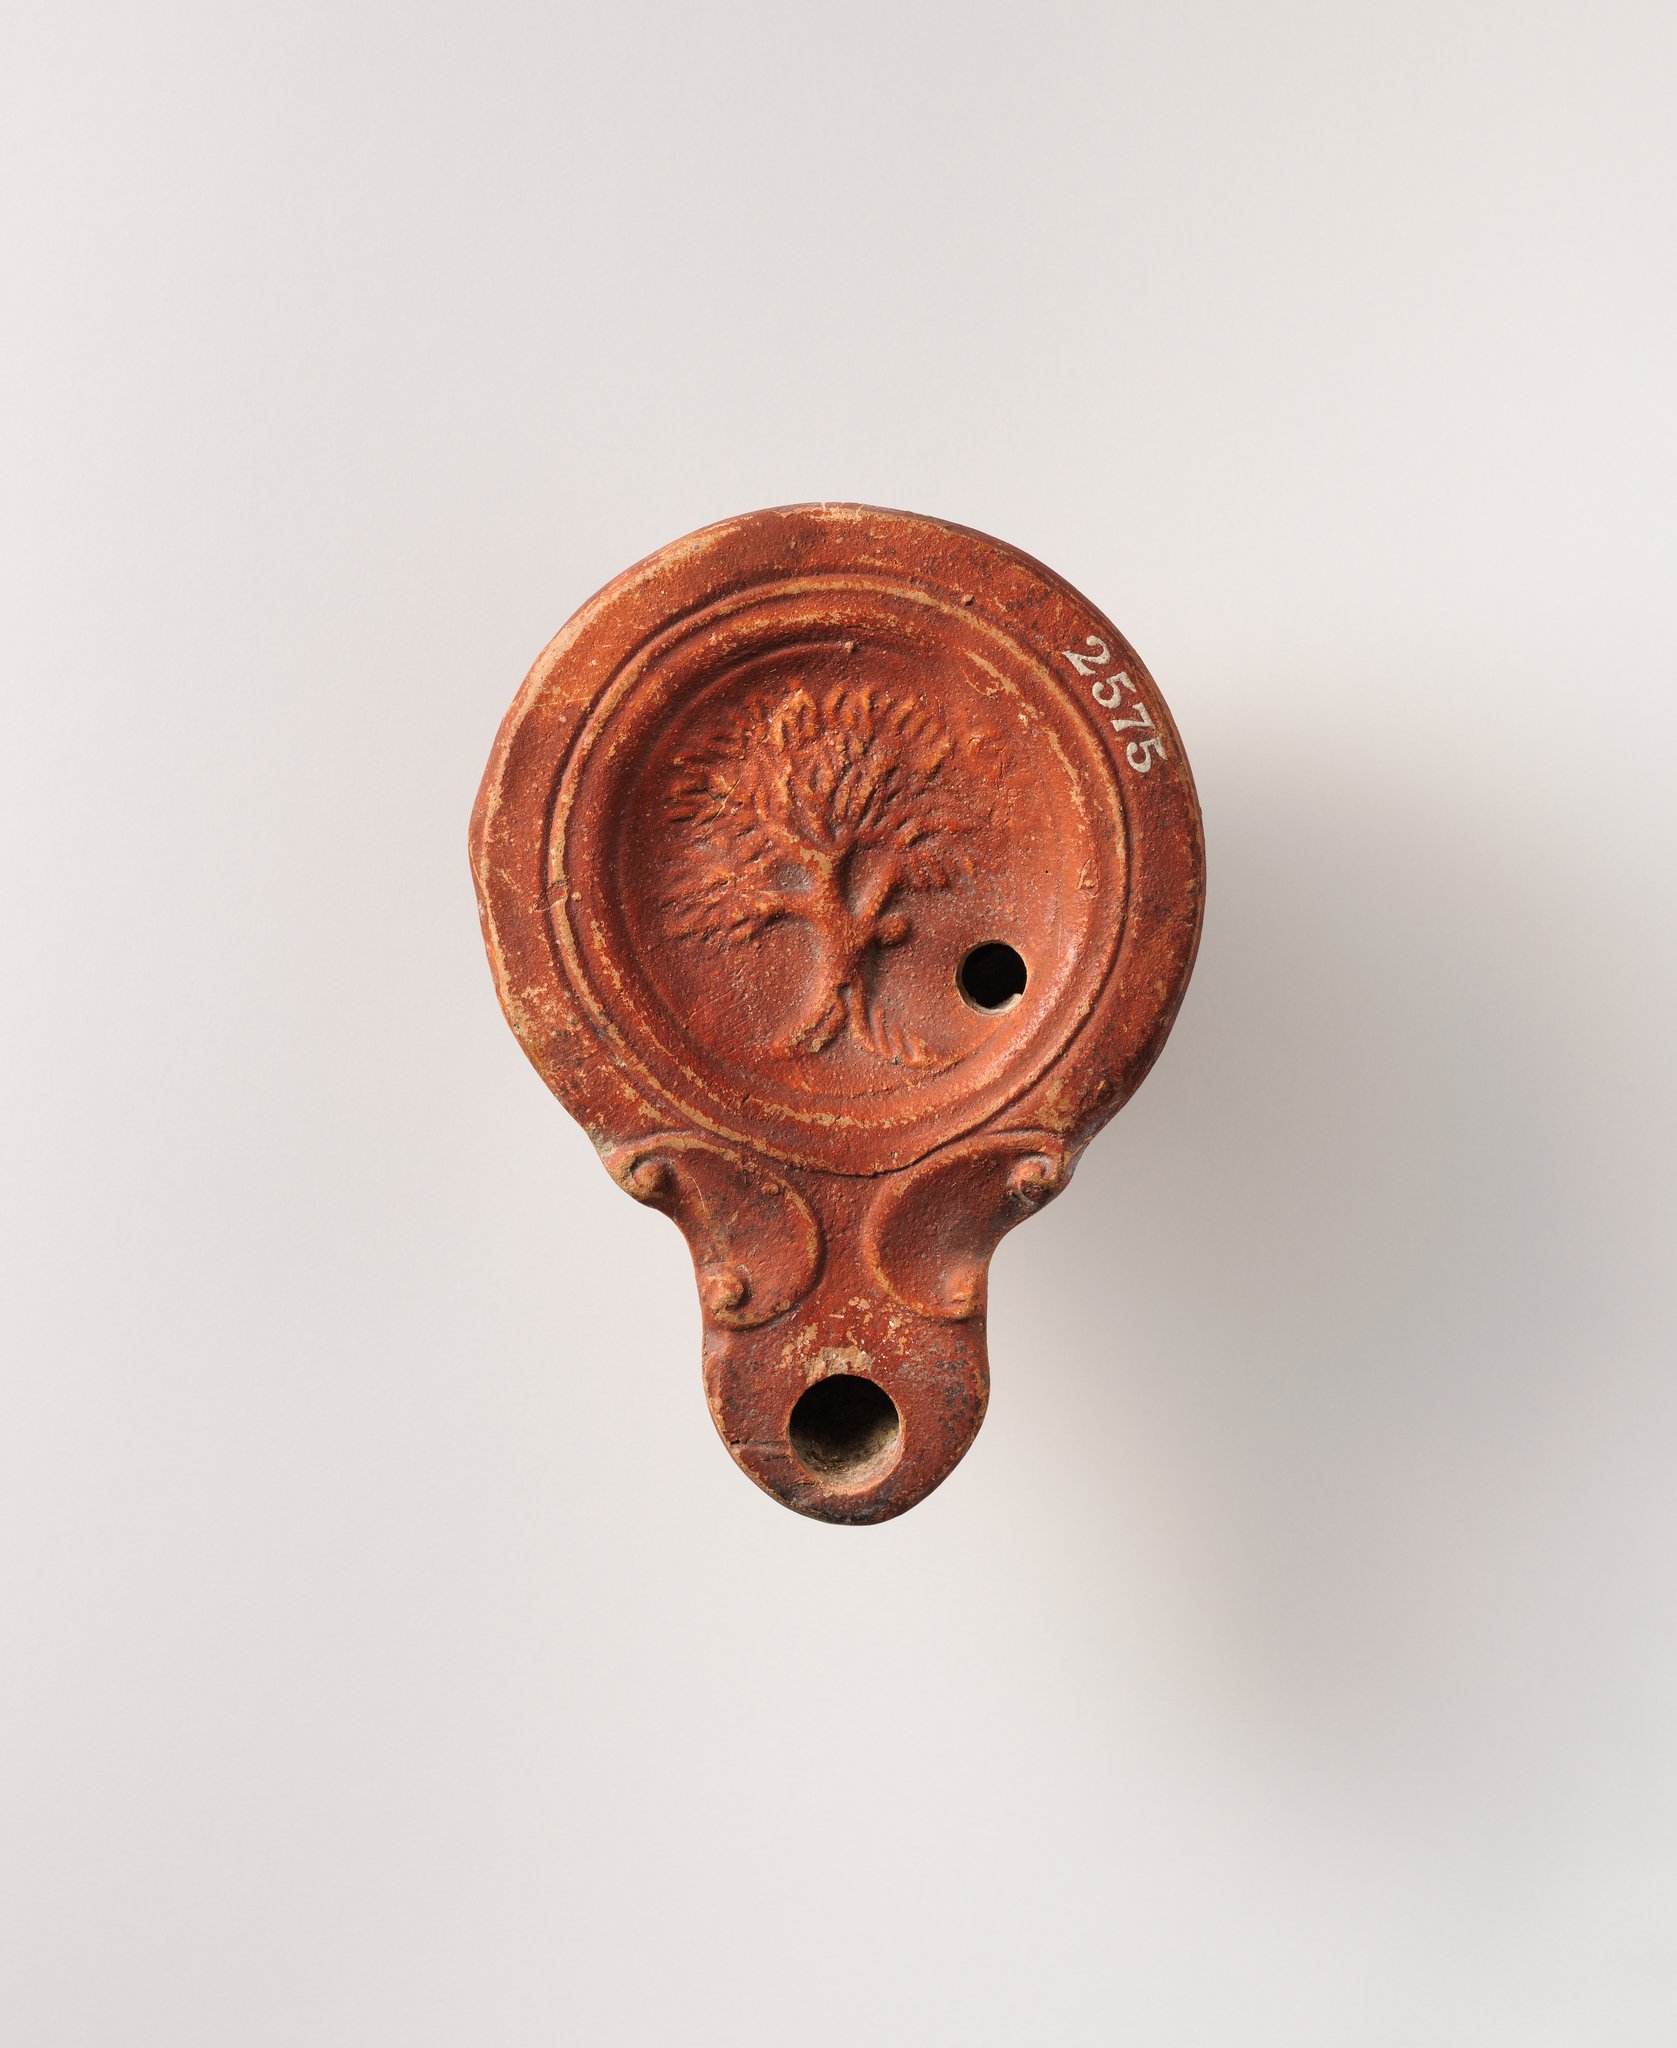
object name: lamp, concave top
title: Terracotta oil lamp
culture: roman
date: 40-100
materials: terracotta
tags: trees